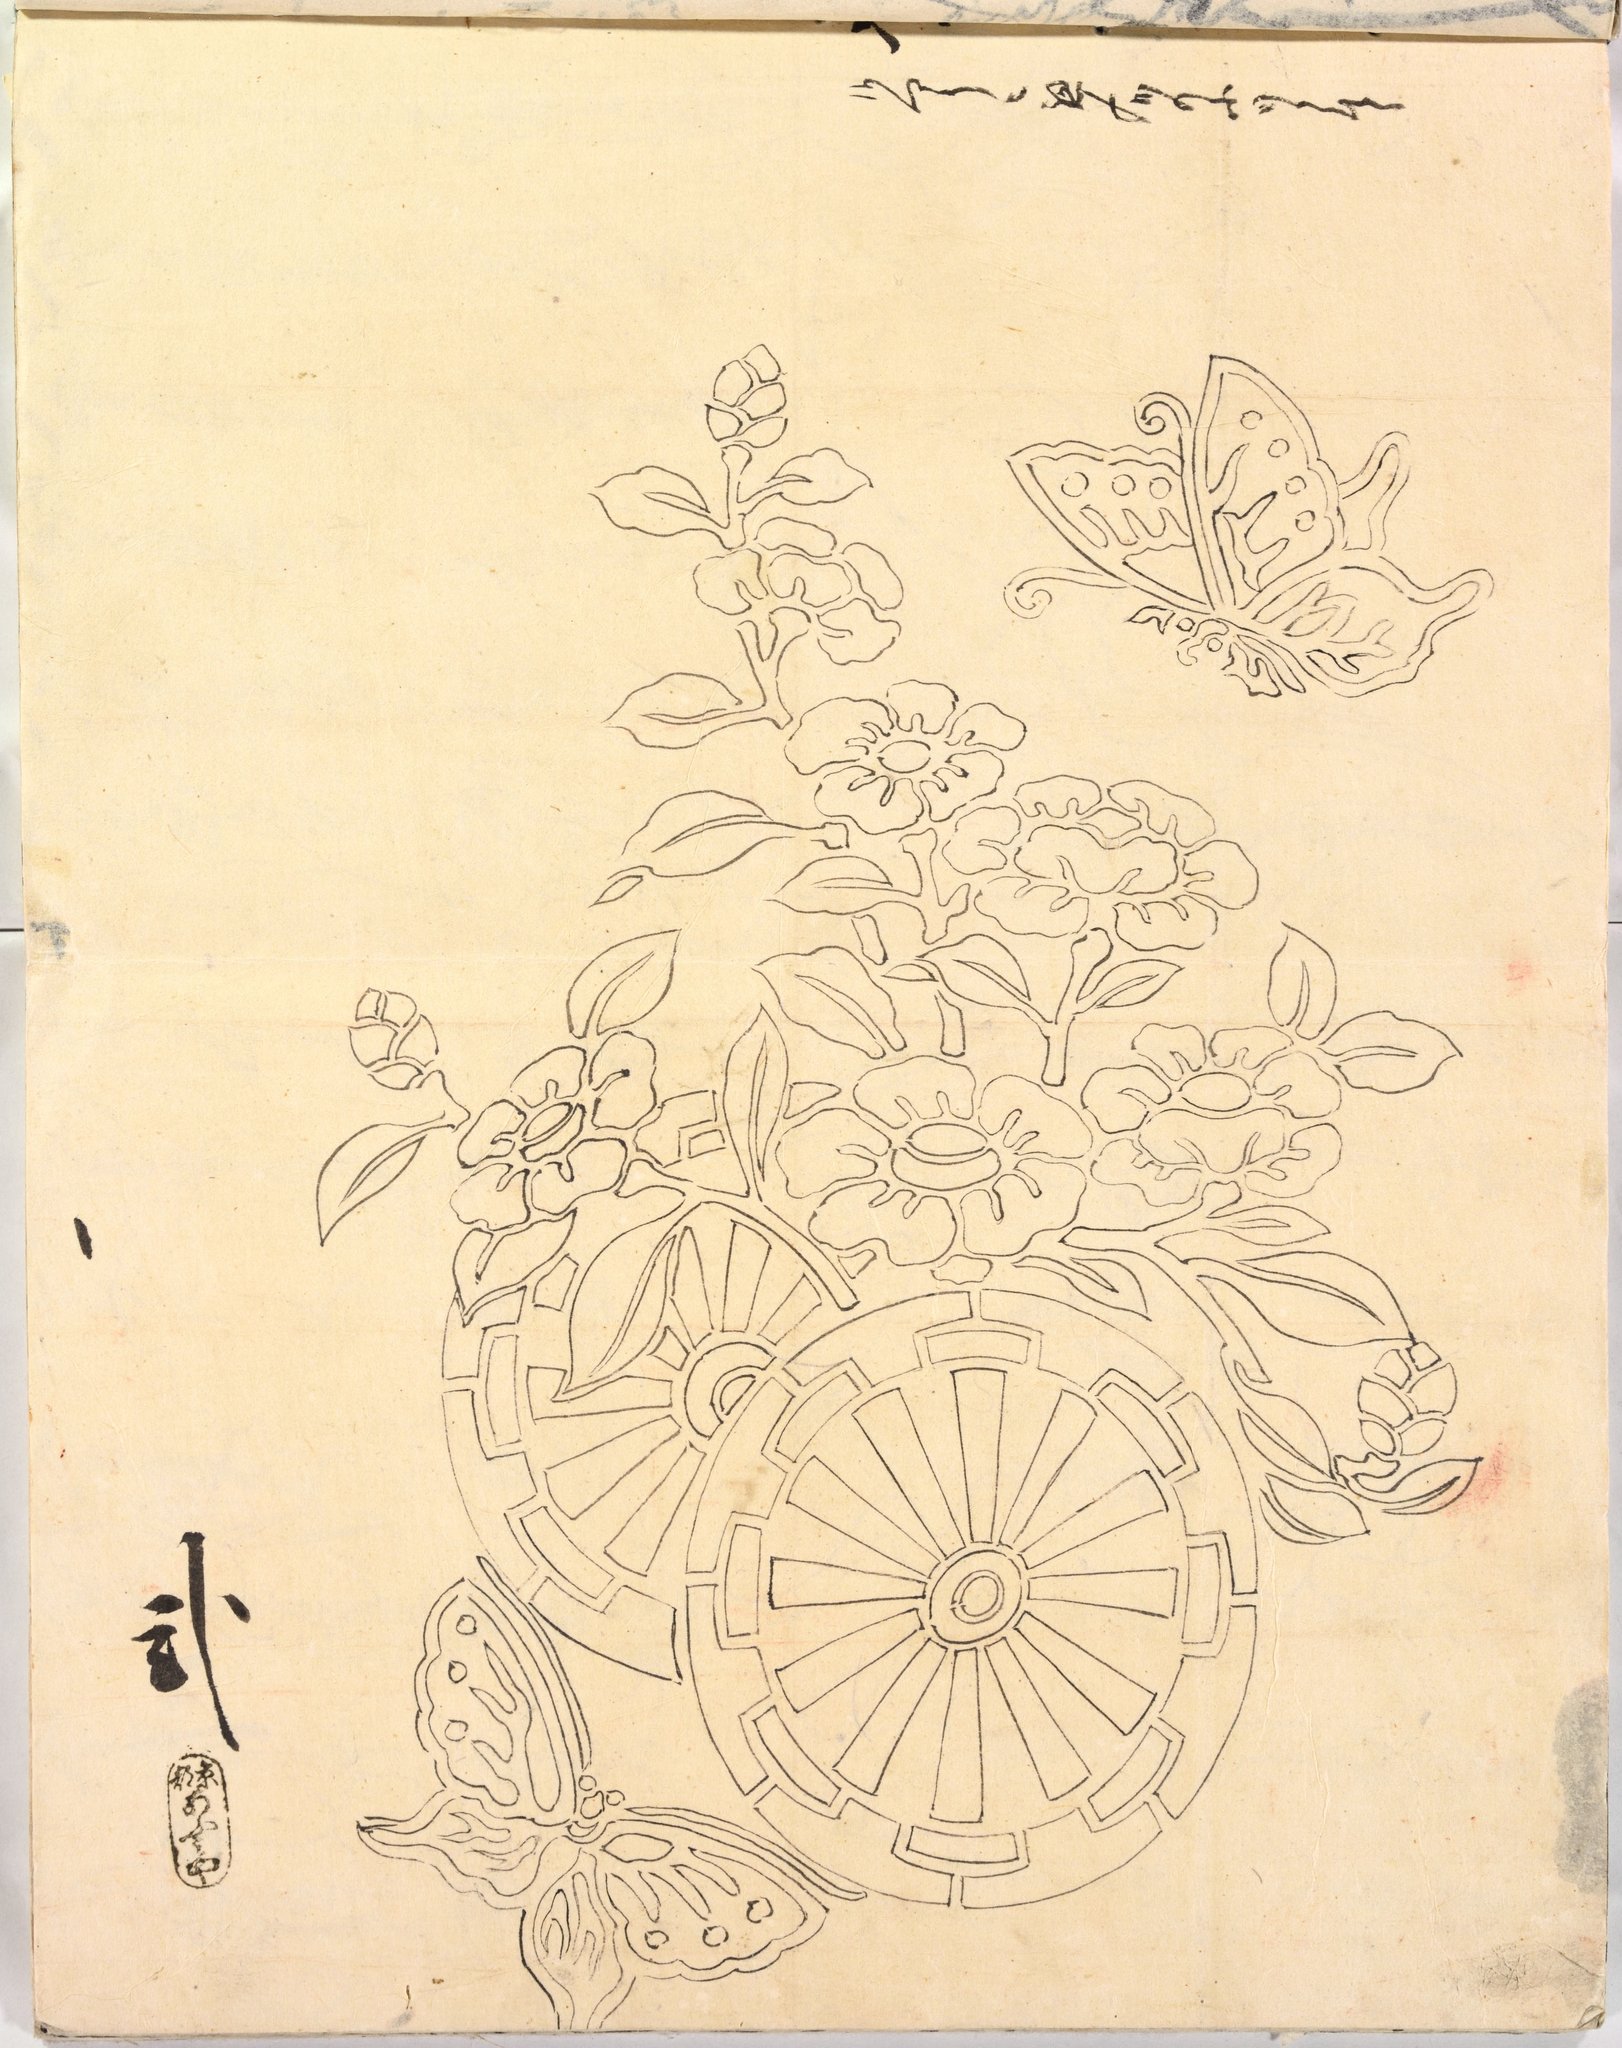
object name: illustrated book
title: Hinagata chō (Model Book)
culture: japanese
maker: unidentified artist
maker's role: artist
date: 1801-1900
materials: ink, paper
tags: butterflies,flowers,leaves